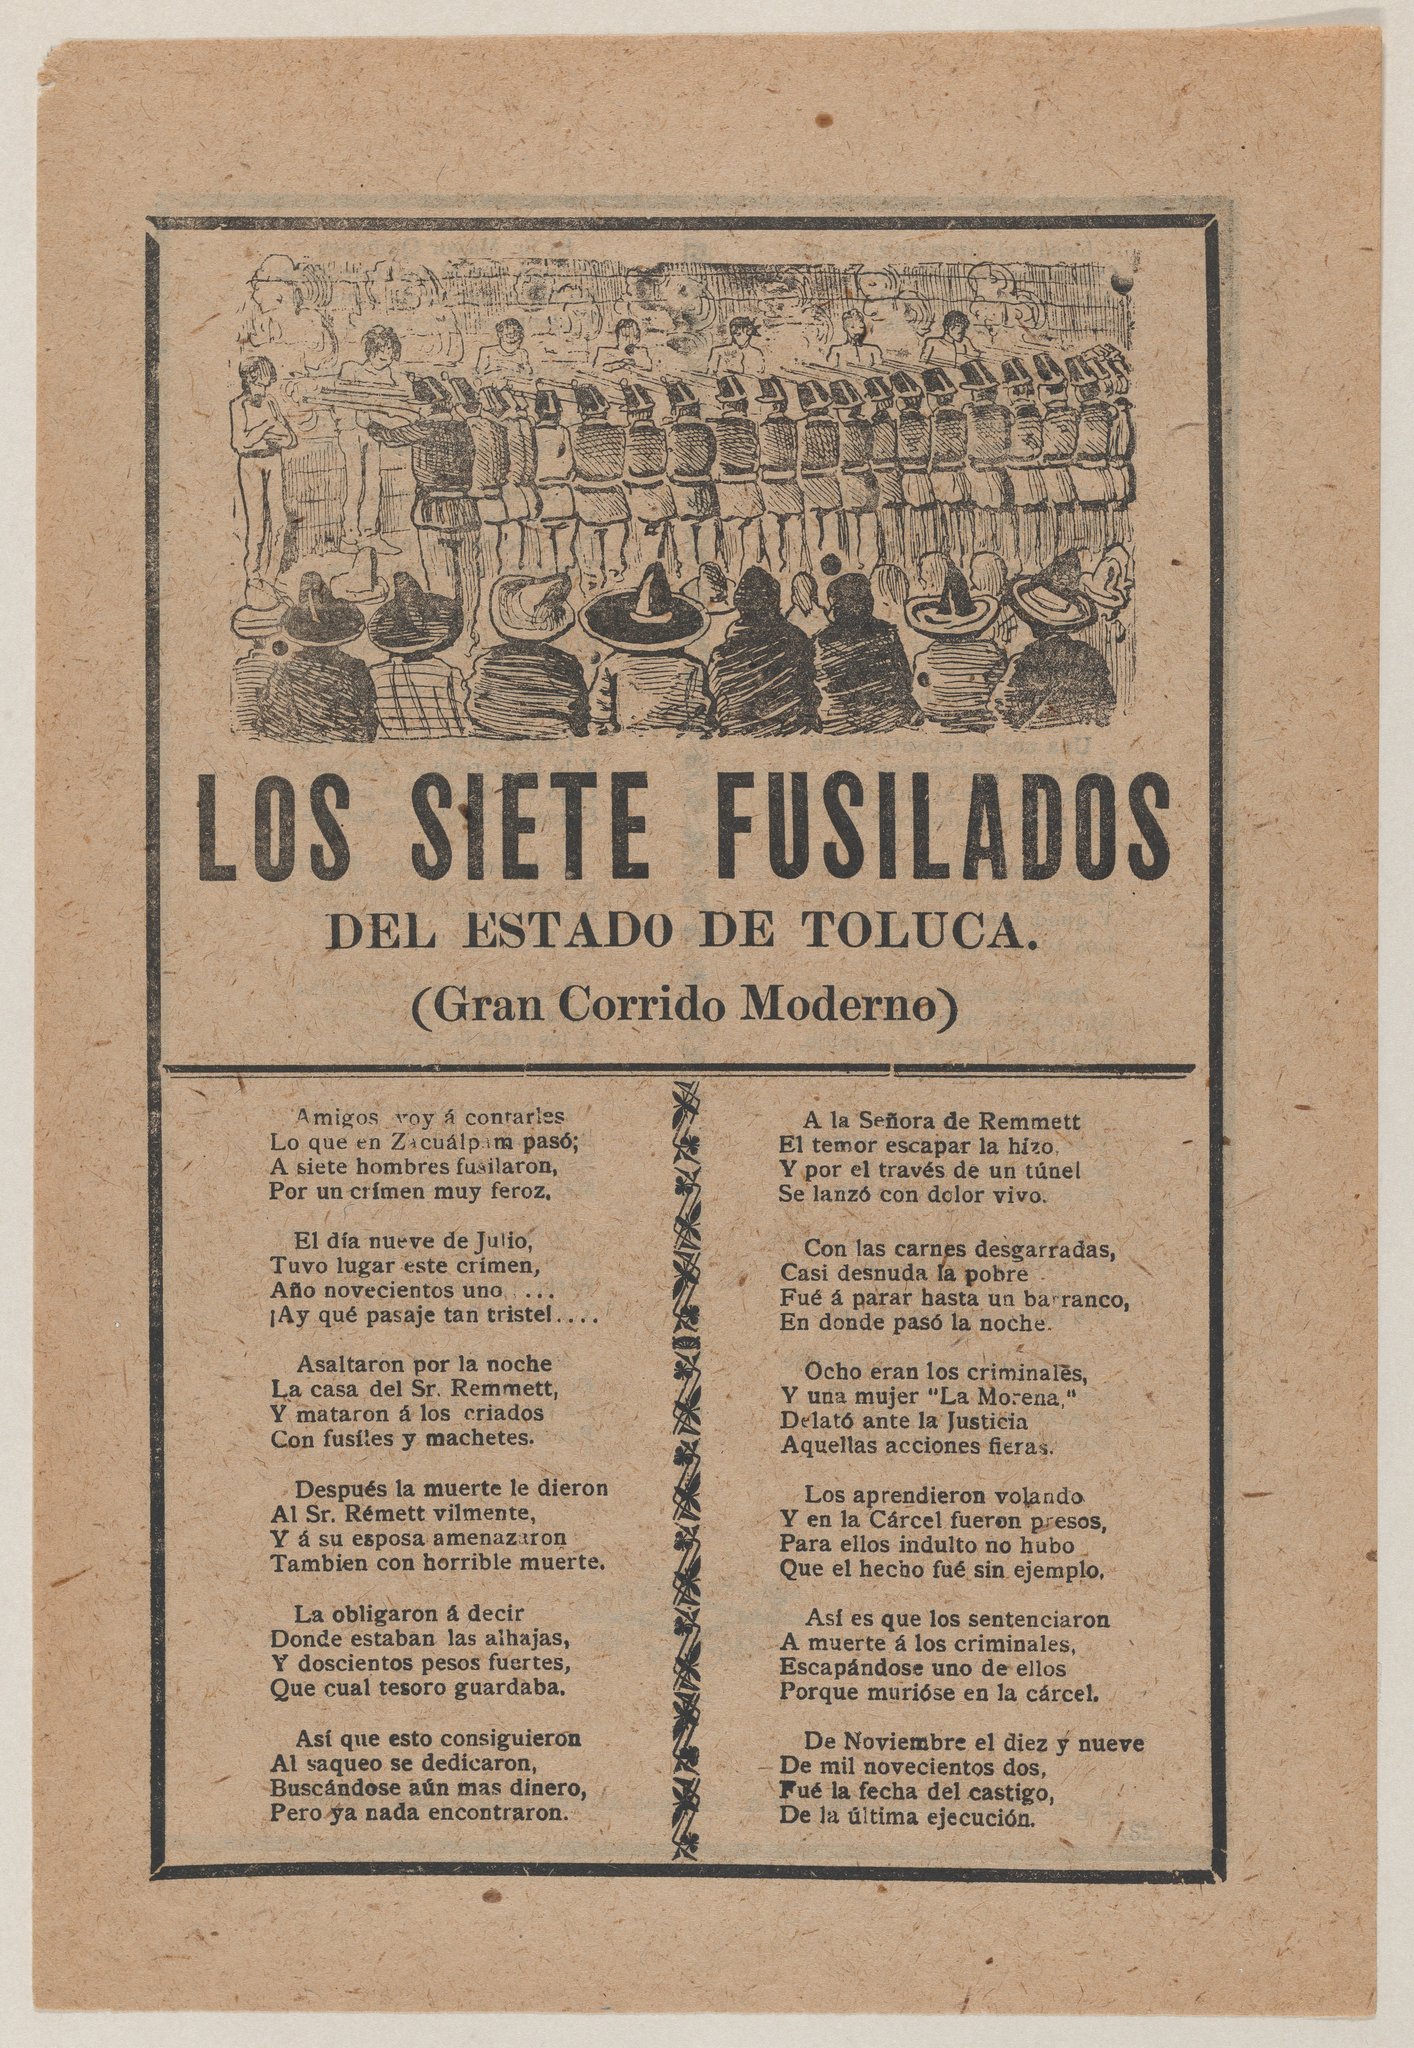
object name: print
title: Broadsheet relating to seven men executed by a firing squad on account of their murder on July 9 of the entire household of Sr Remmett in Toluca, a corrido in the bottom section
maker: josé guadalupe posada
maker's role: artist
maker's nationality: mexican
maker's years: 1852-1913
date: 1902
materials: paper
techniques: letterpress, lithography